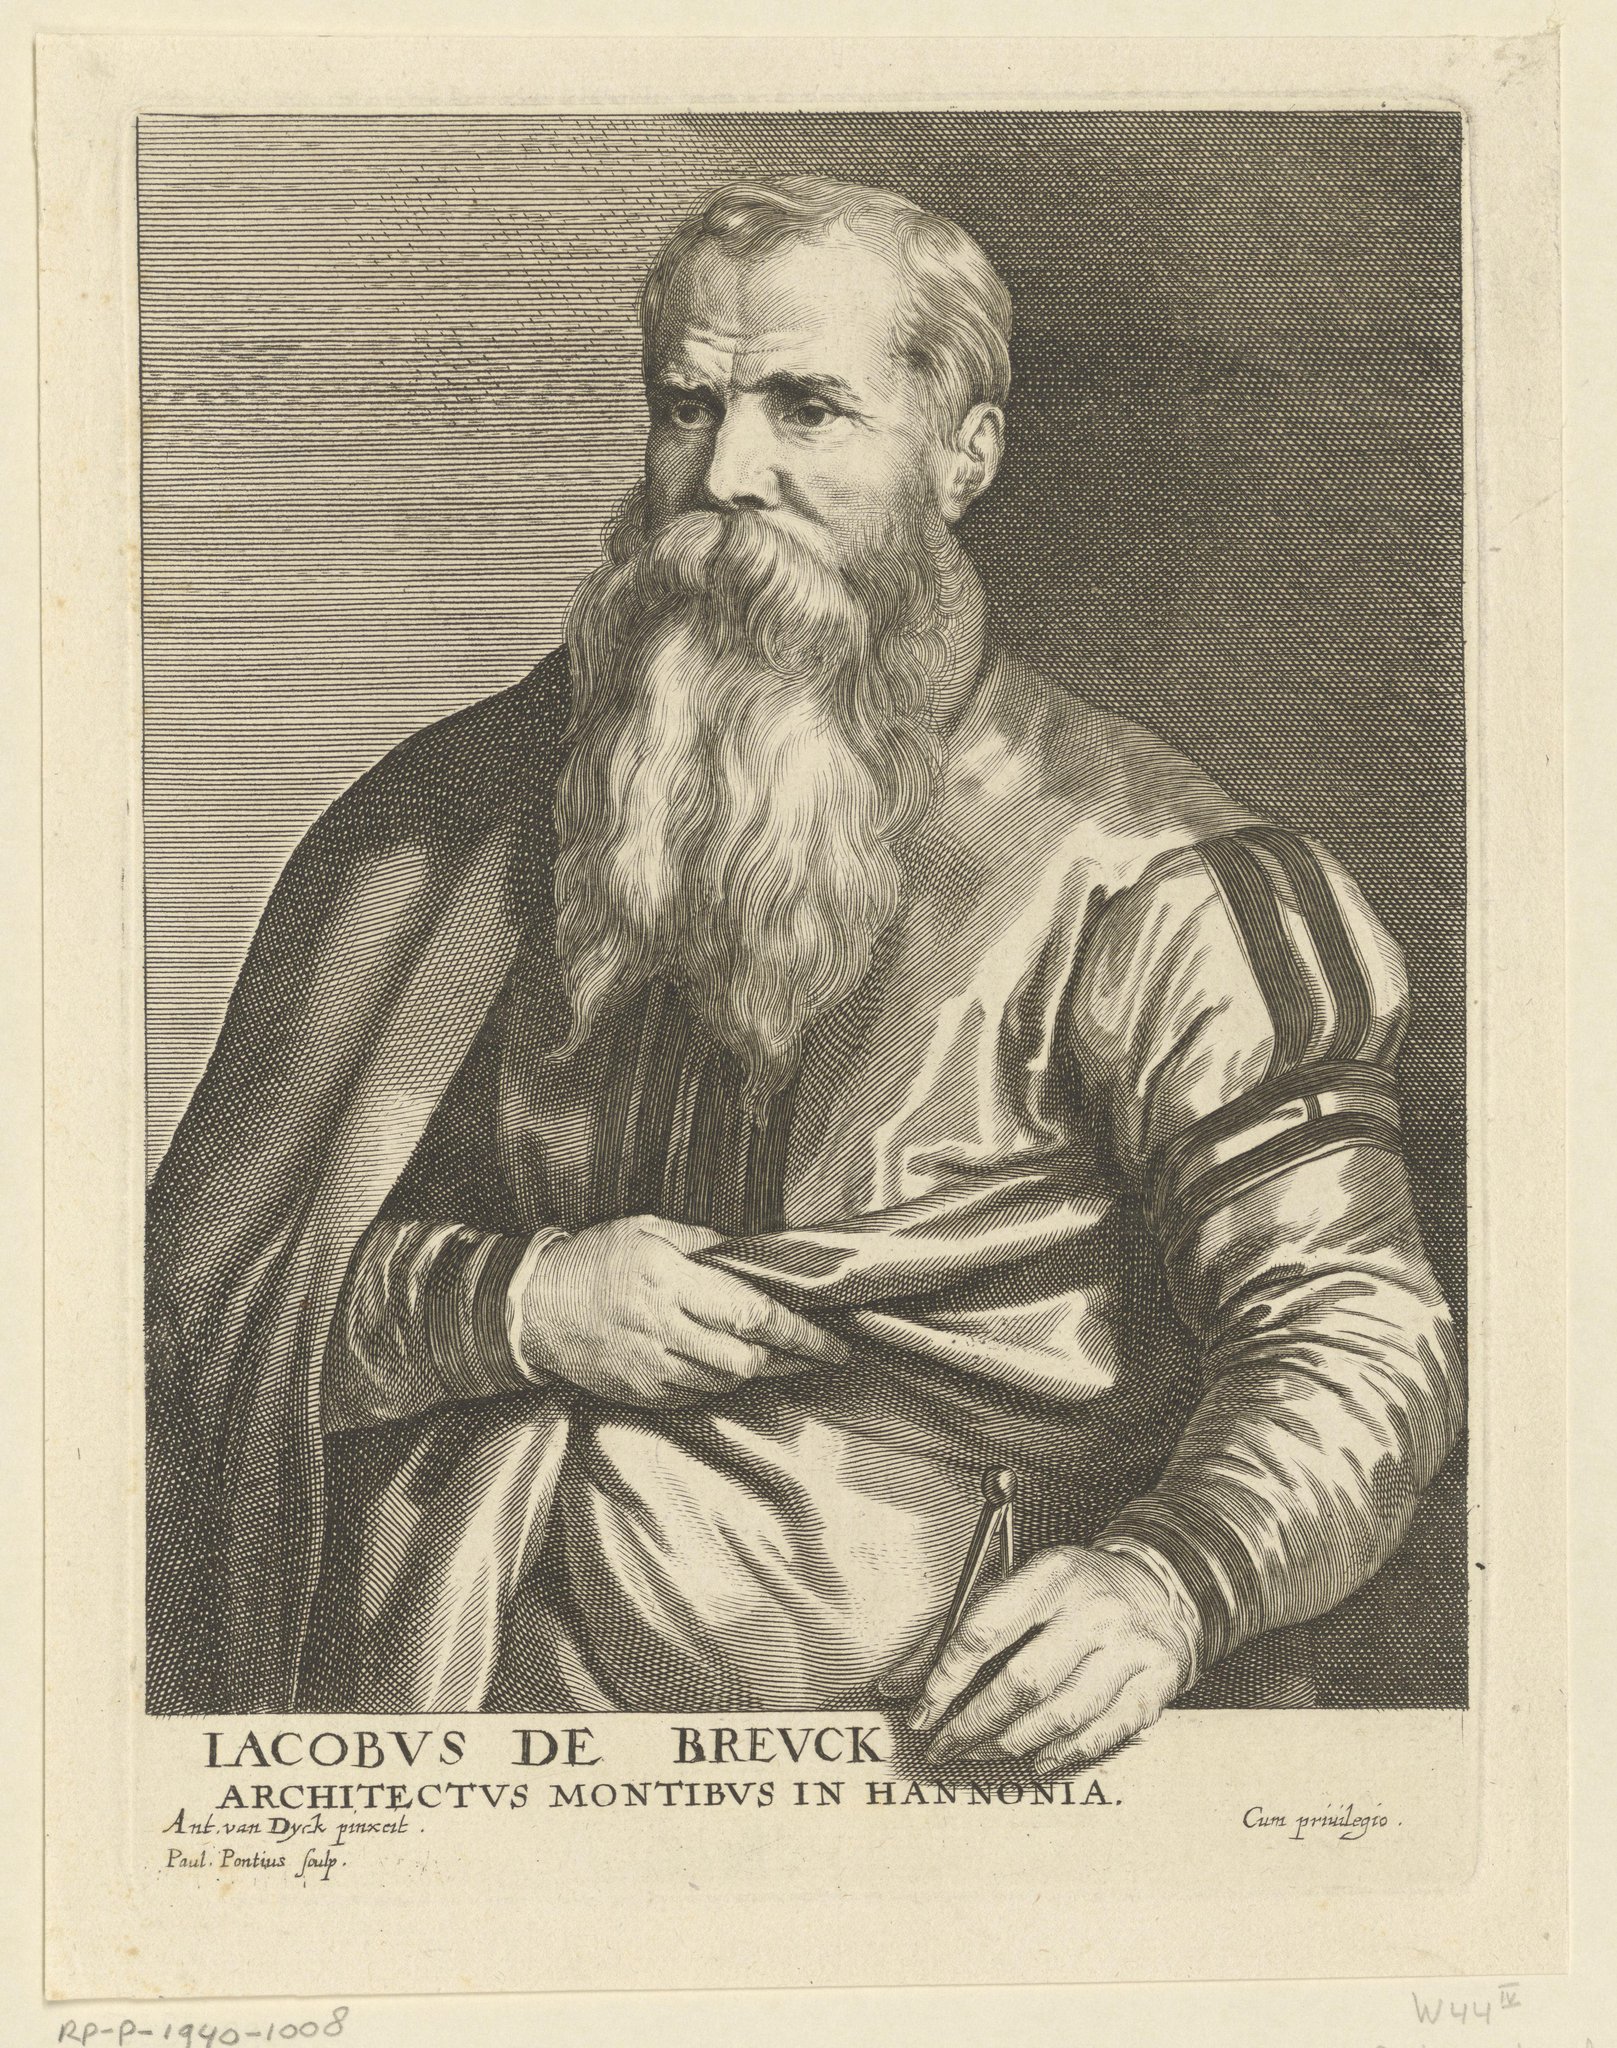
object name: print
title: Portret van Jacob de Breuck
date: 1613-1657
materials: paper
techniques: engraving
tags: sculptor, historical persons, portrait, self-portrait of architect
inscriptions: collector's mark: Lugt 2166, collector's mark: Lugt 2760